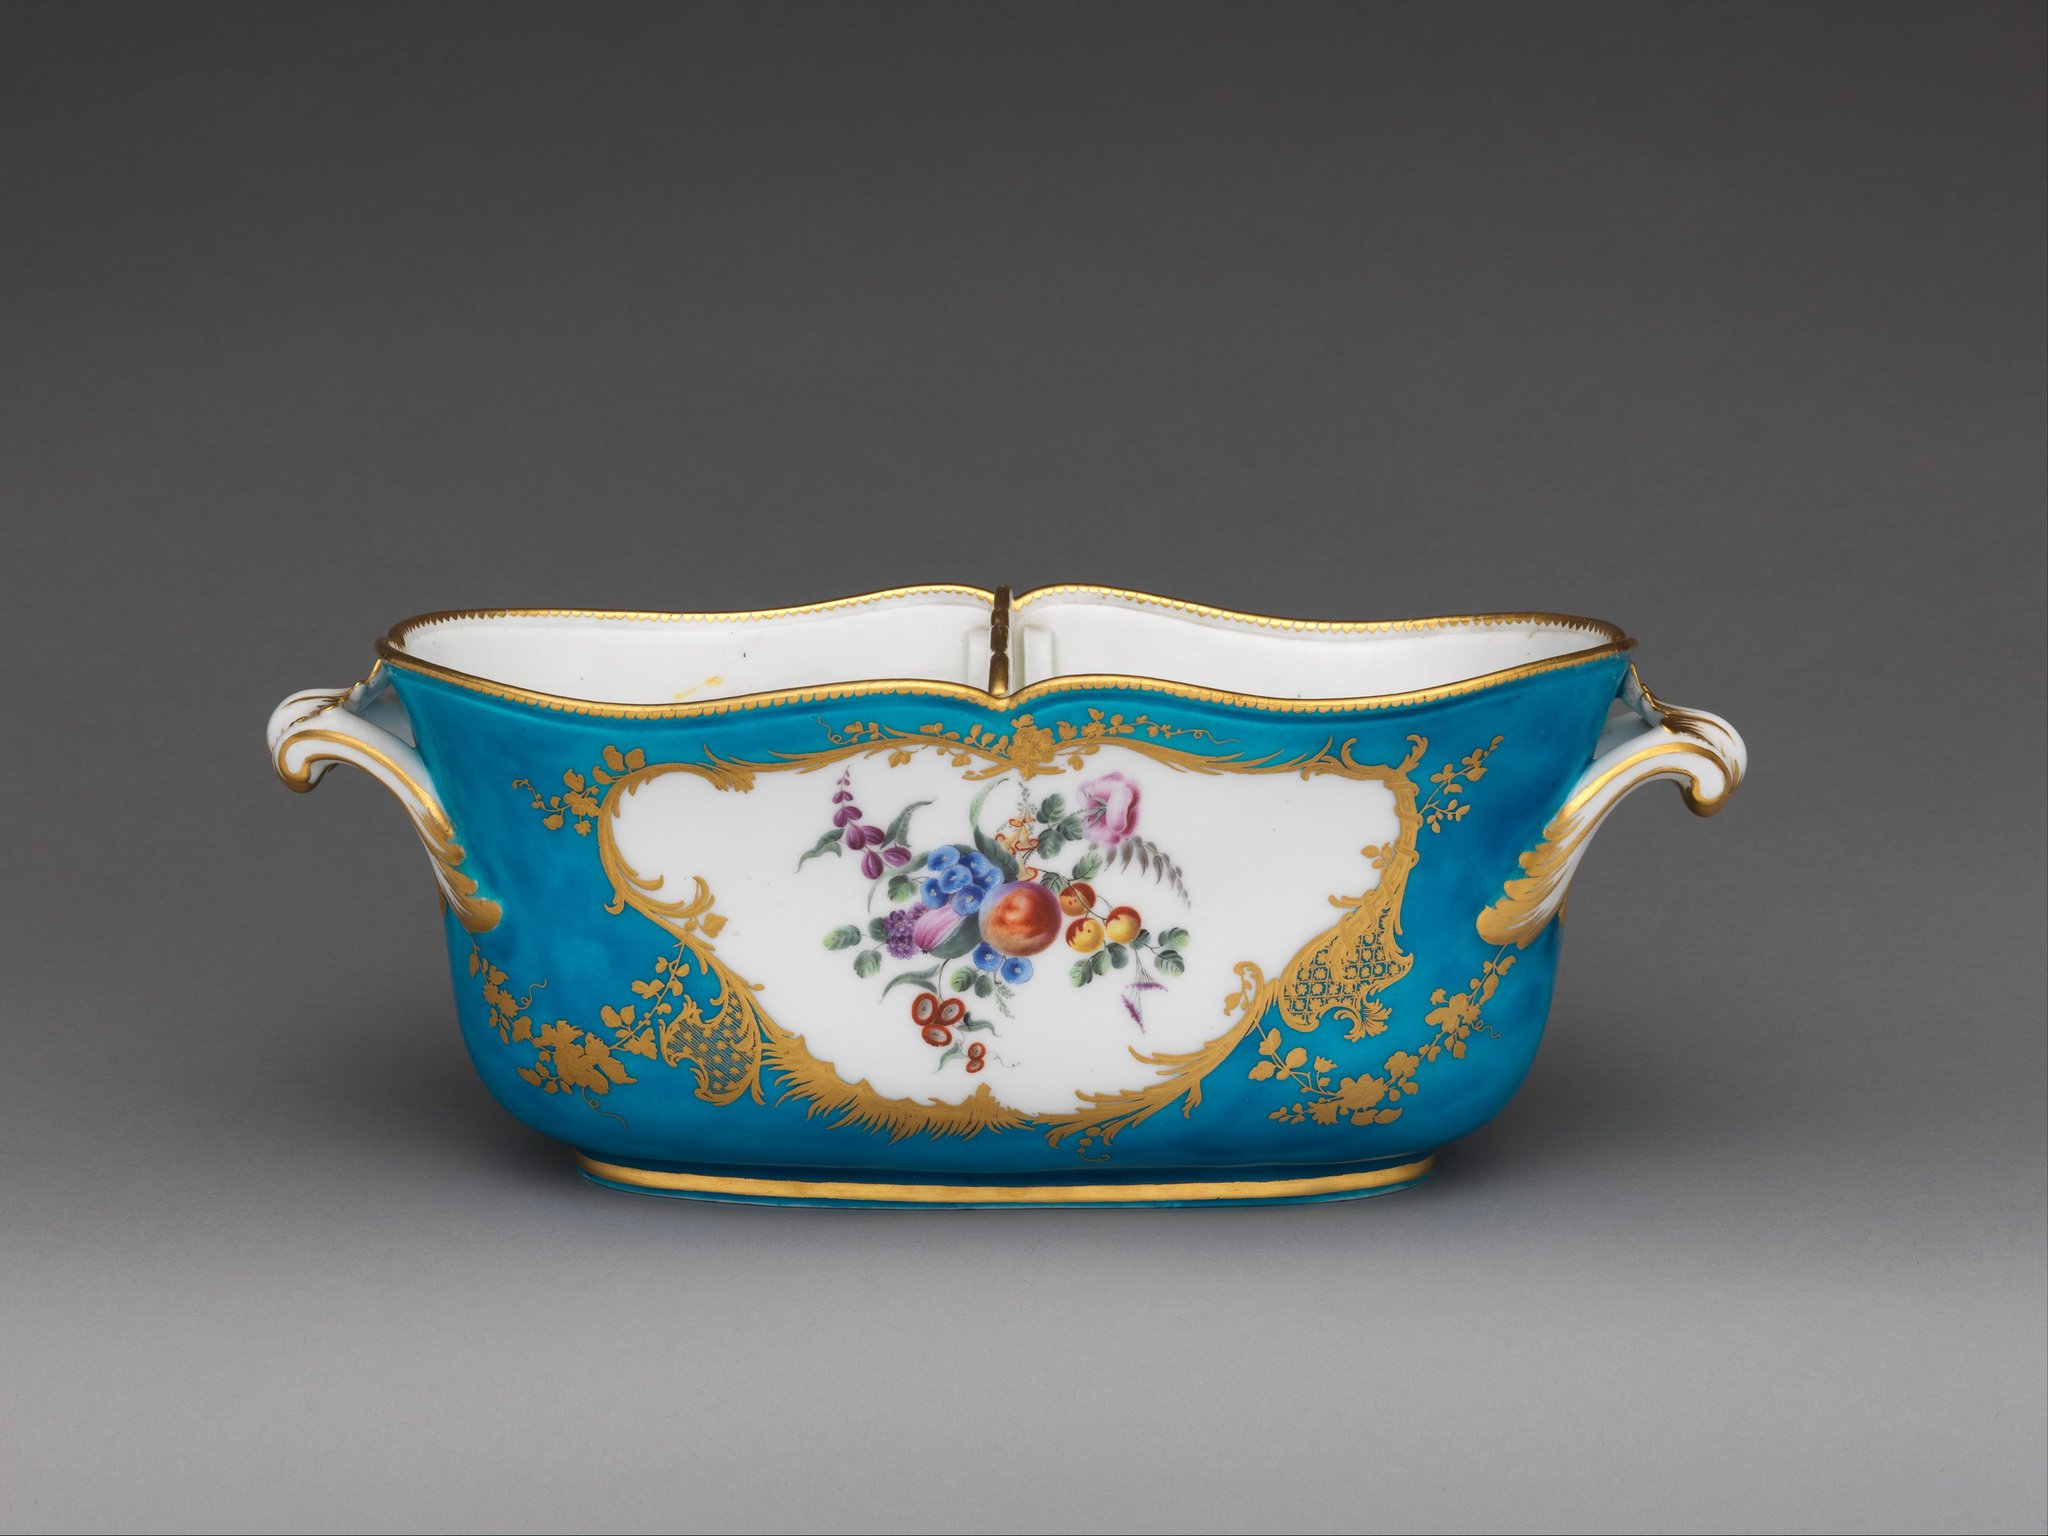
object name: liqueur bottle cooler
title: Liqueur bottle cooler (seau ovale à liqueur)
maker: vincennes manufactory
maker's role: manufactory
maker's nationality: french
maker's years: 1740-1756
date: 1755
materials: soft paste porcelain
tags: fruit,flowers